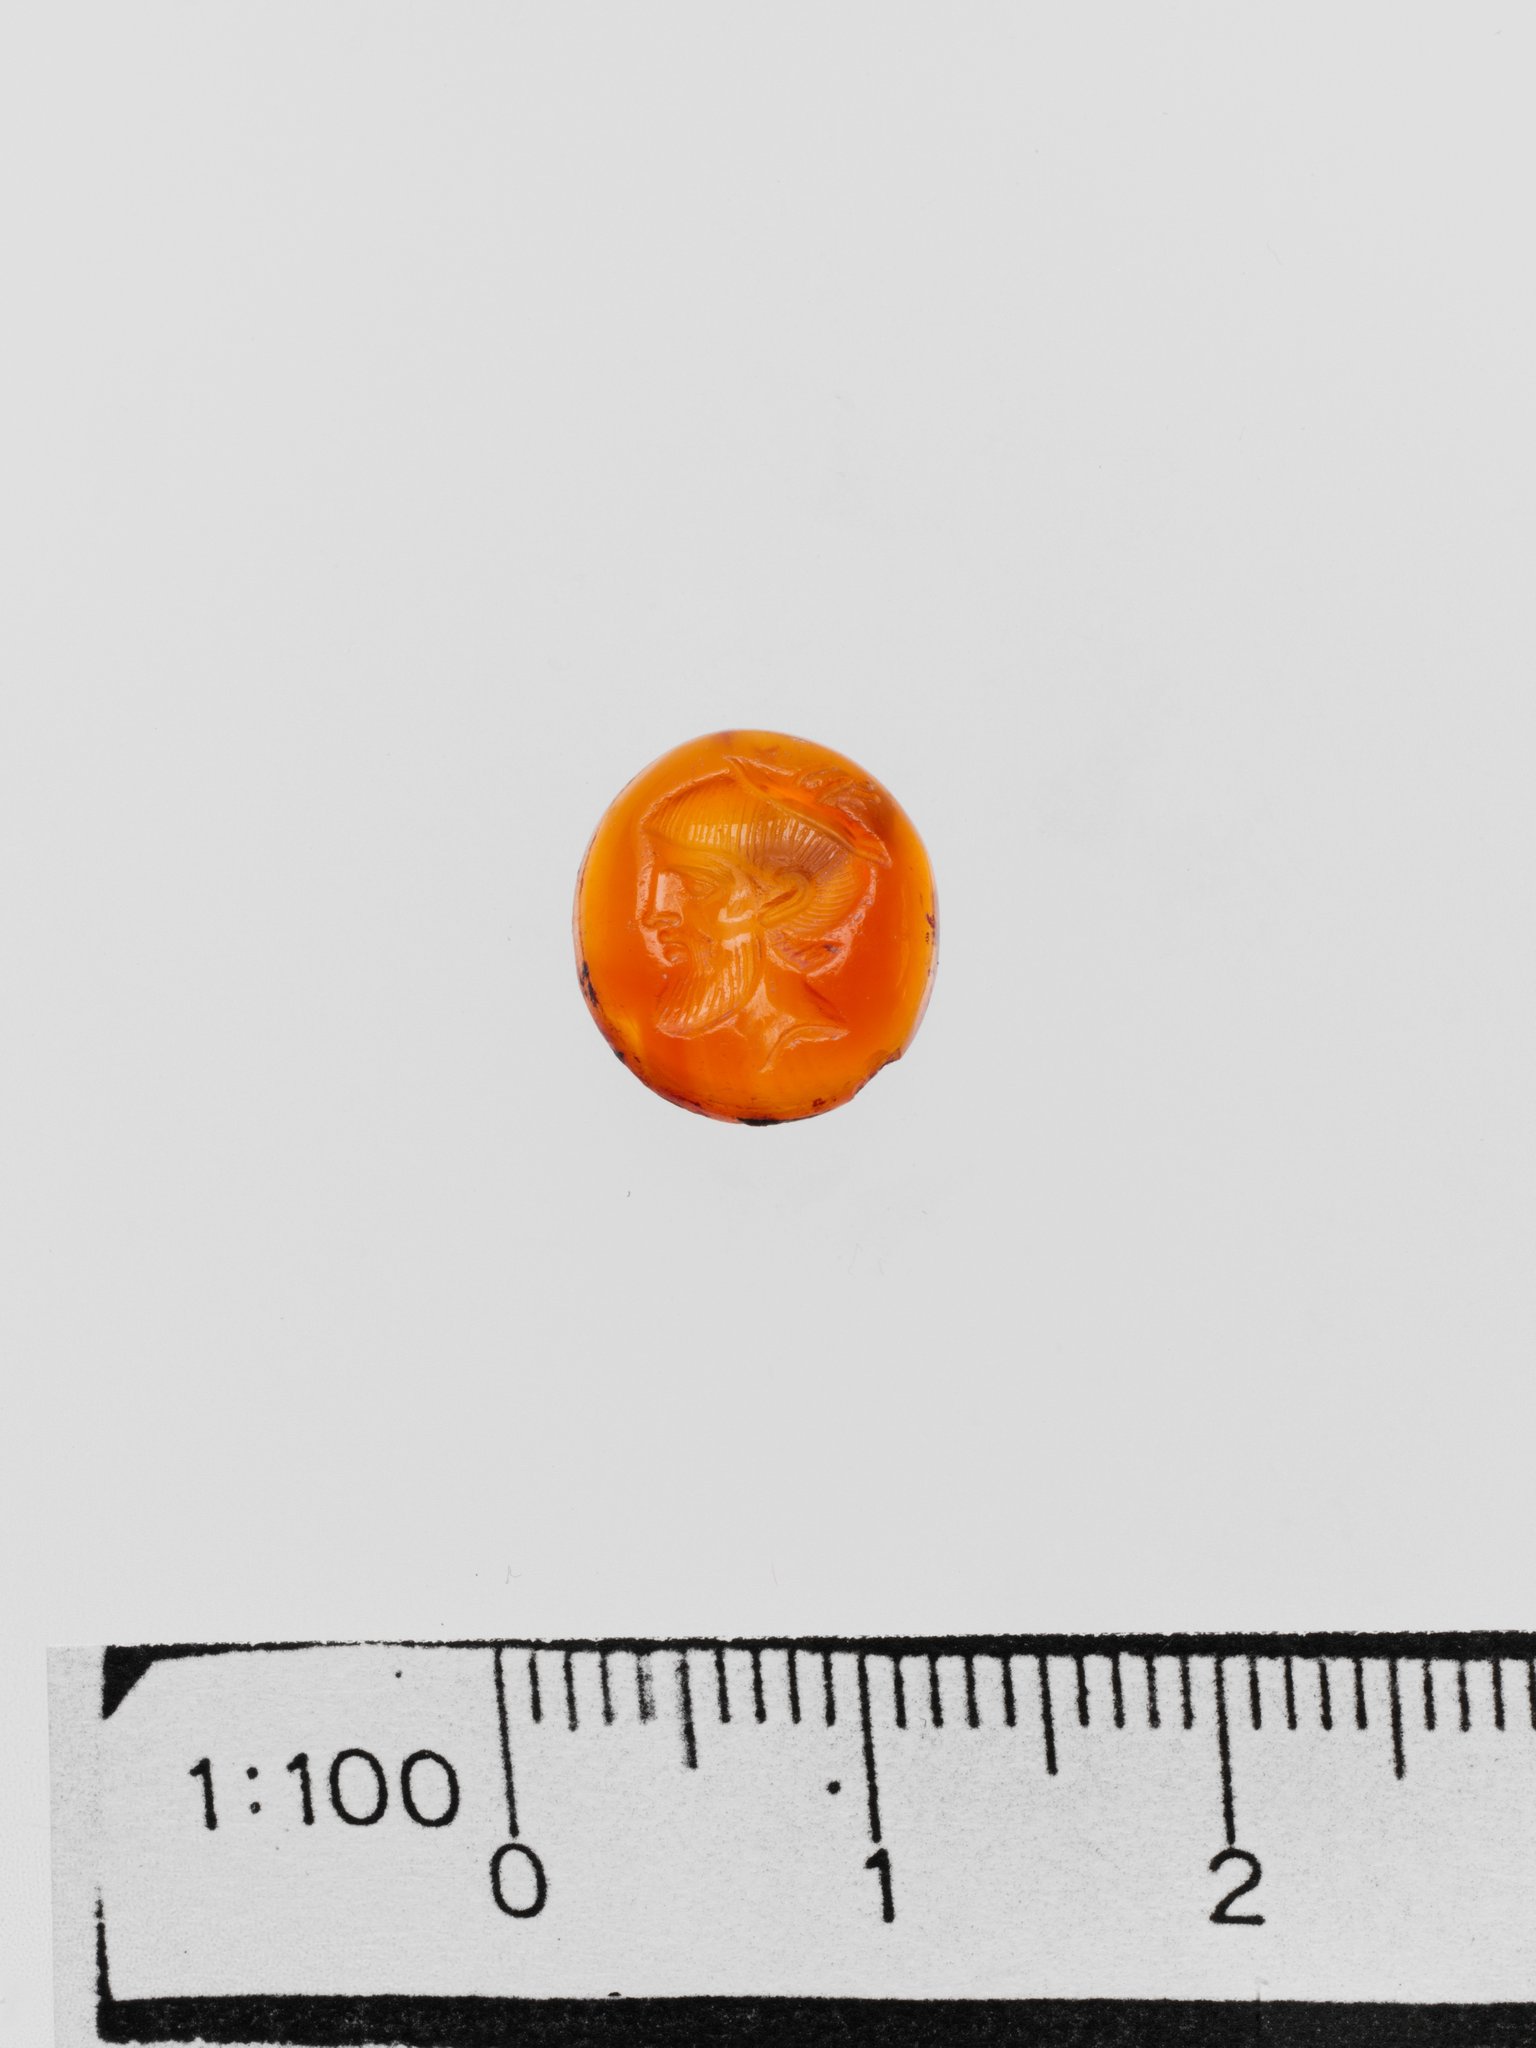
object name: intaglio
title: Carnelian ring stone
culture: italic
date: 300-101 BCE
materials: gemstone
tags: heads,hermes